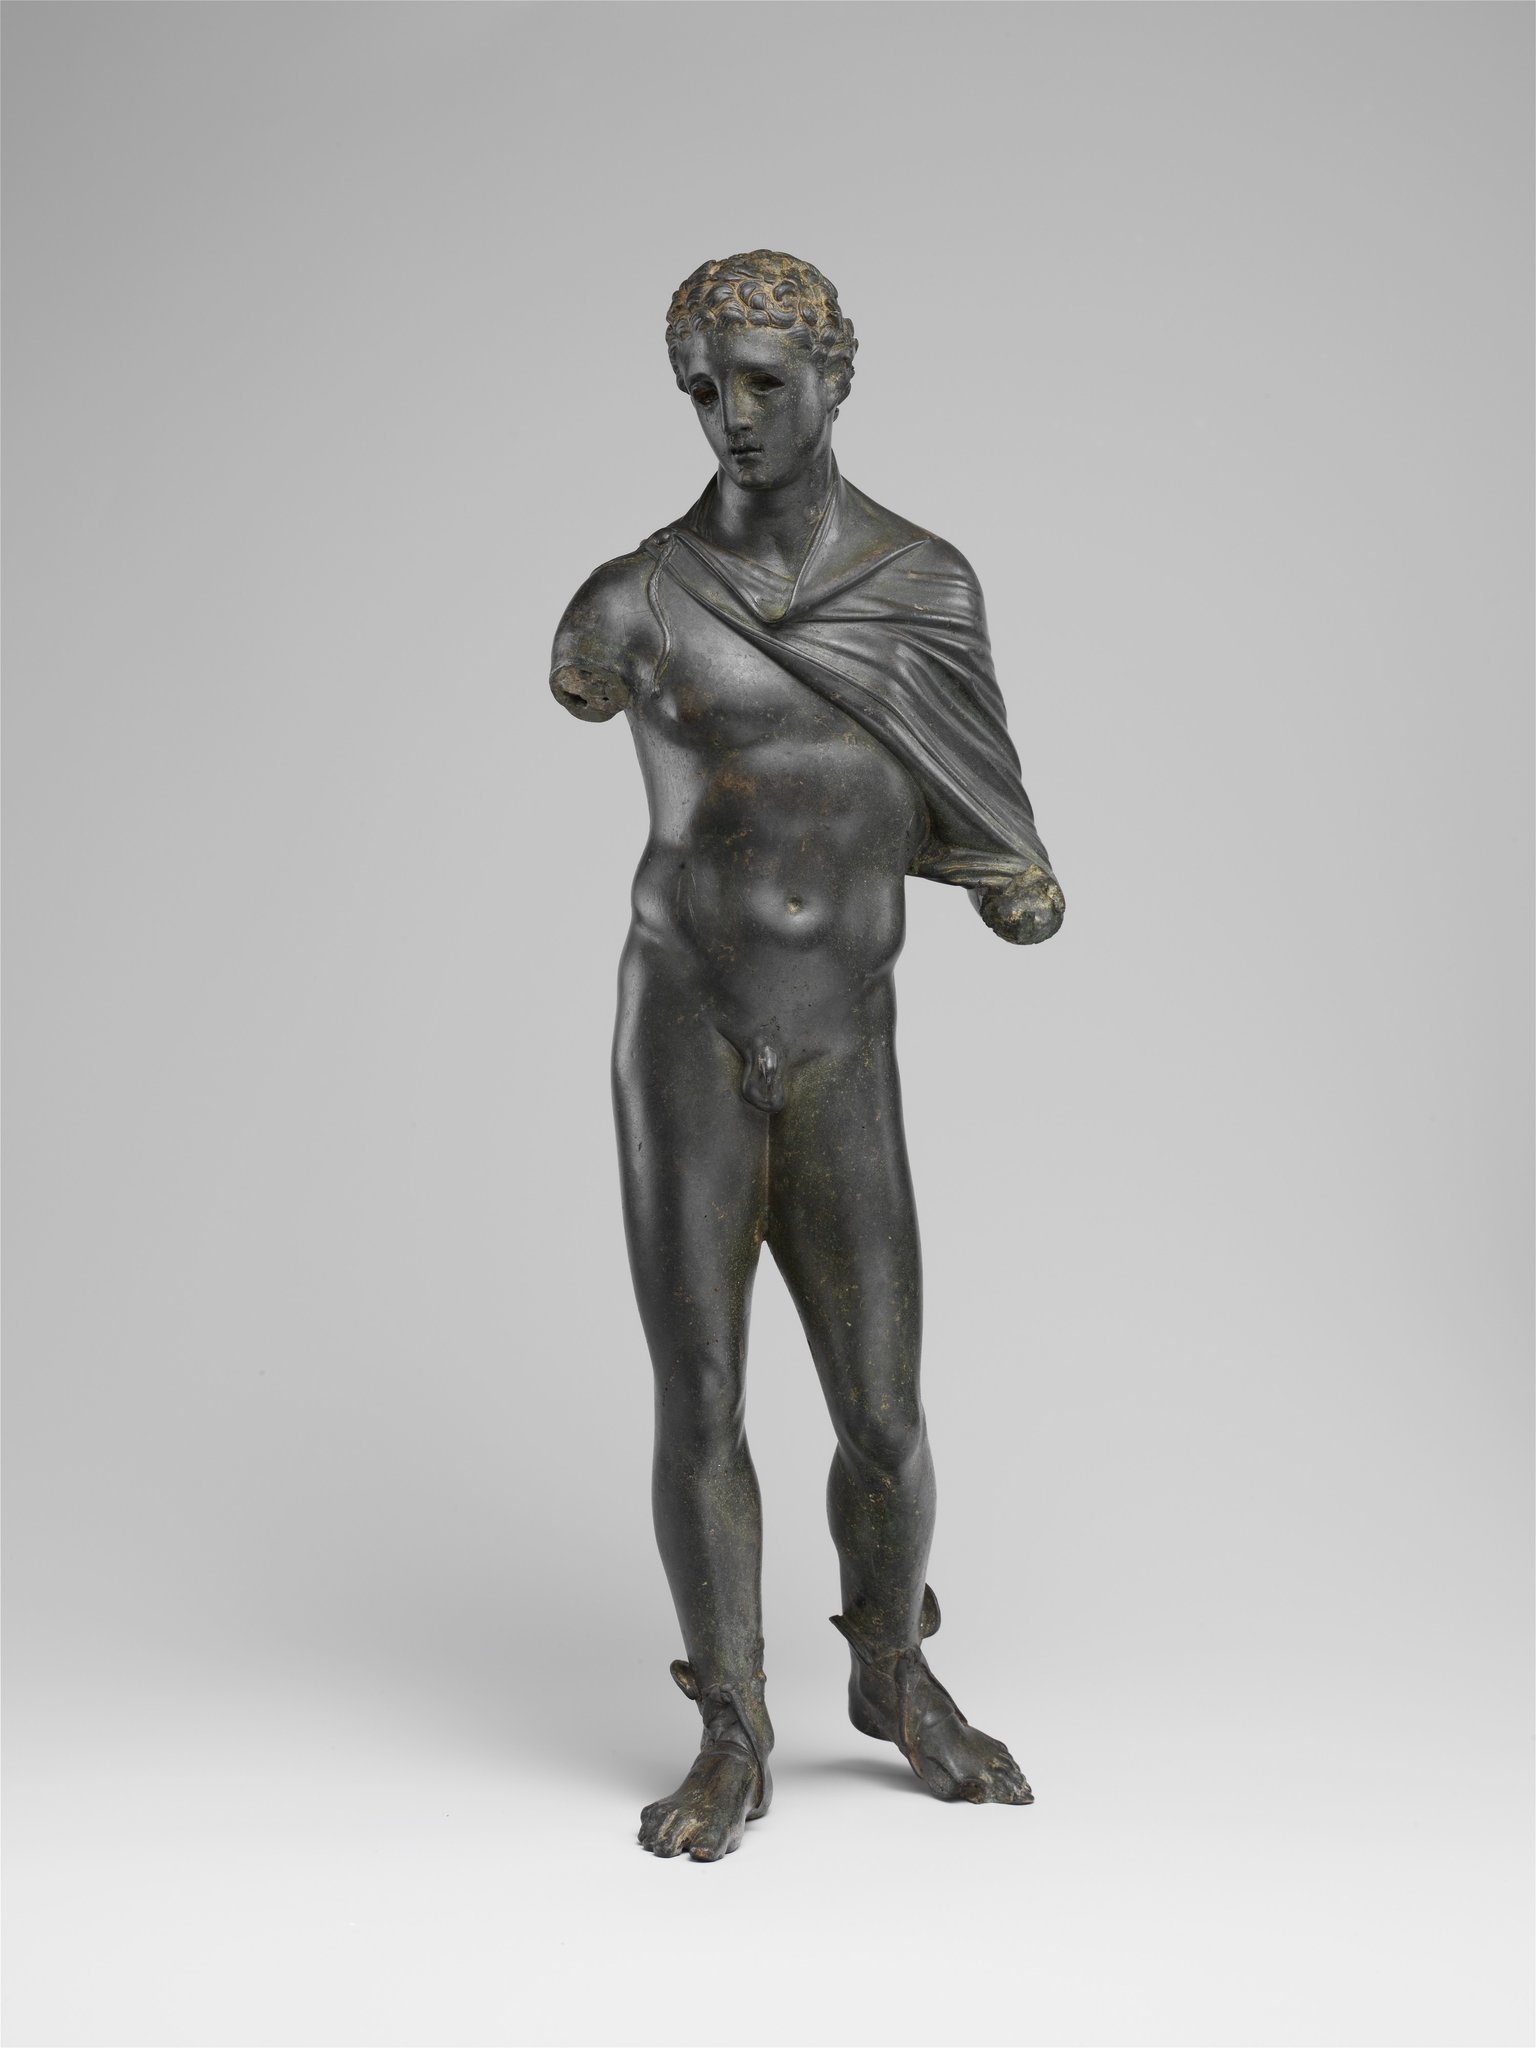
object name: statuette of hermes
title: Bronze statuette of Hermes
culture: greek or roman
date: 100 BCE-100 CE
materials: bronze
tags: hermes